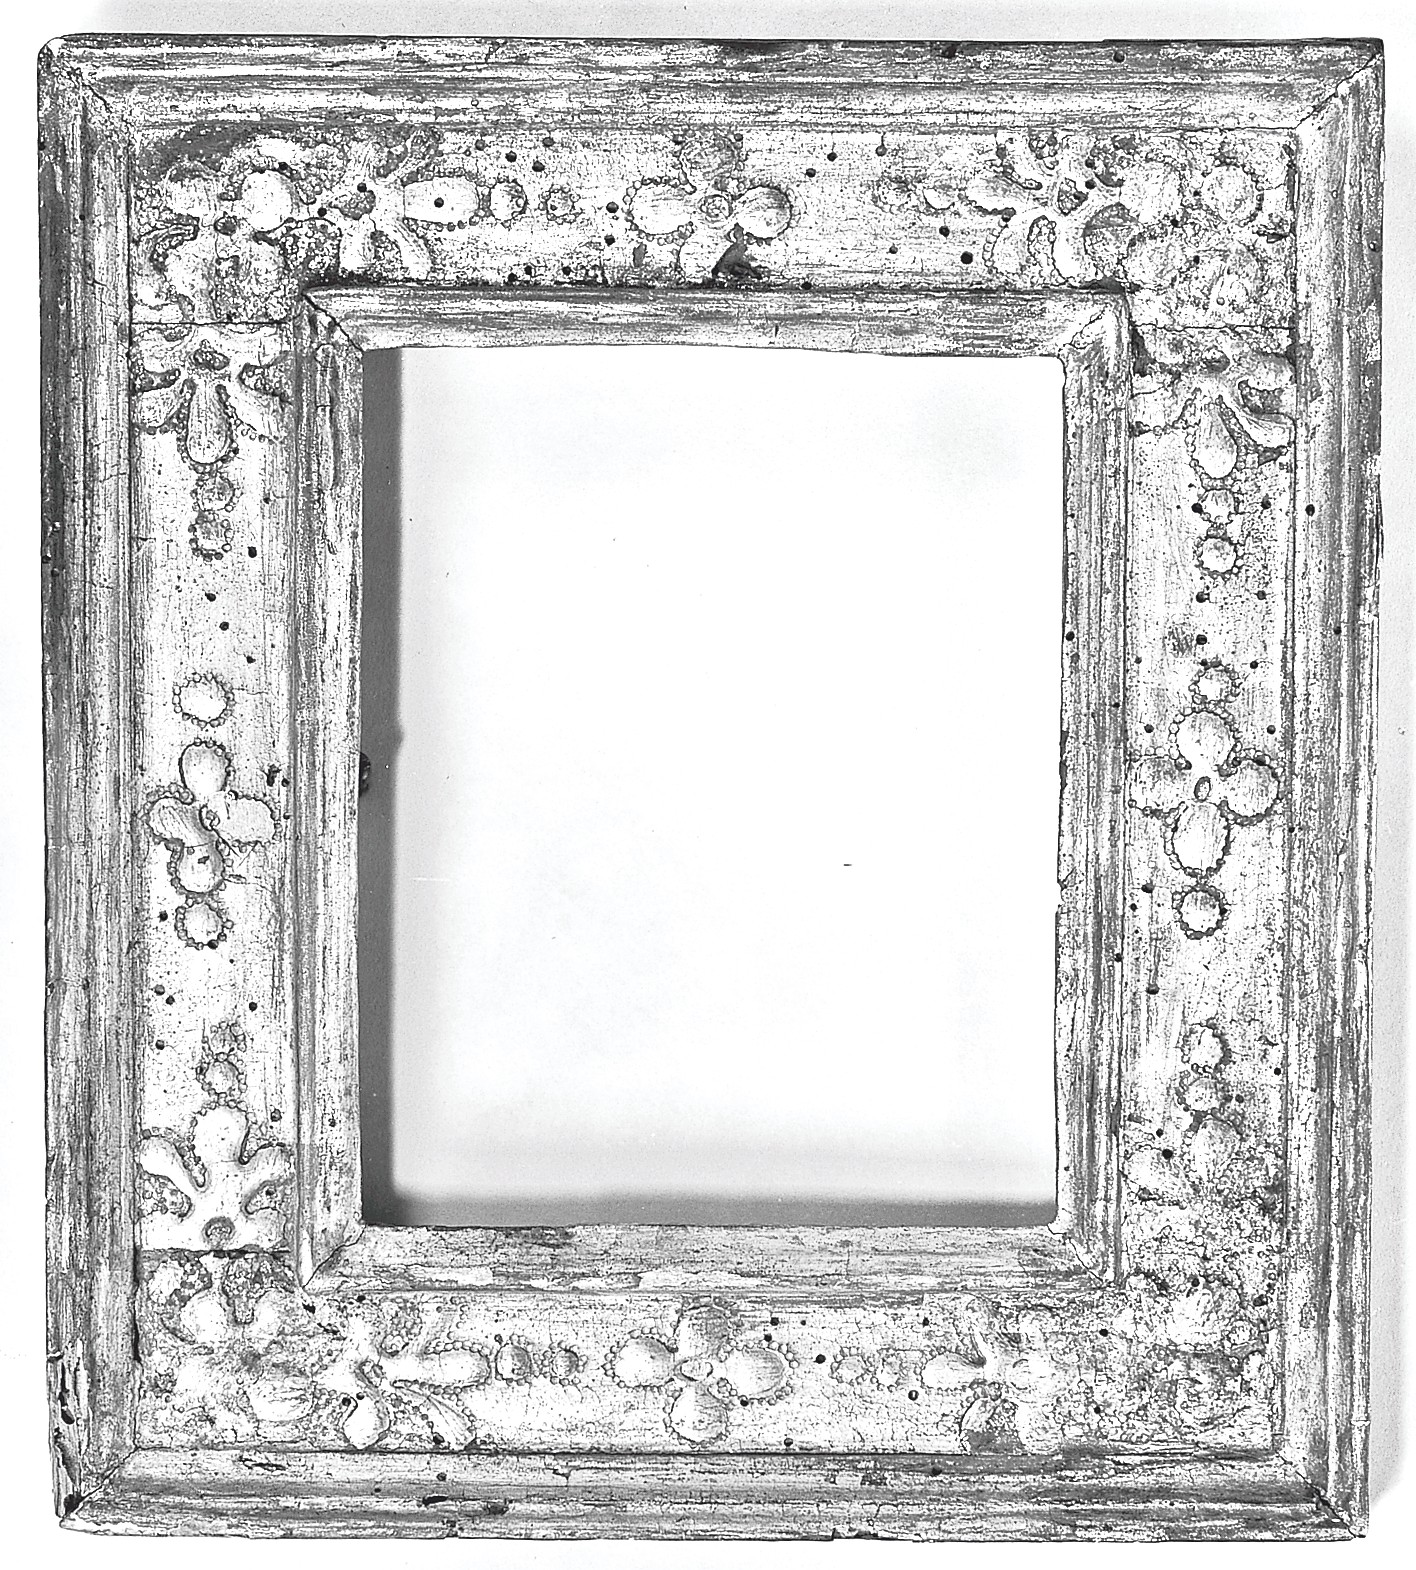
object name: frame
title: Cassetta Frame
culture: italian, veneto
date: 1567-1600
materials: wood